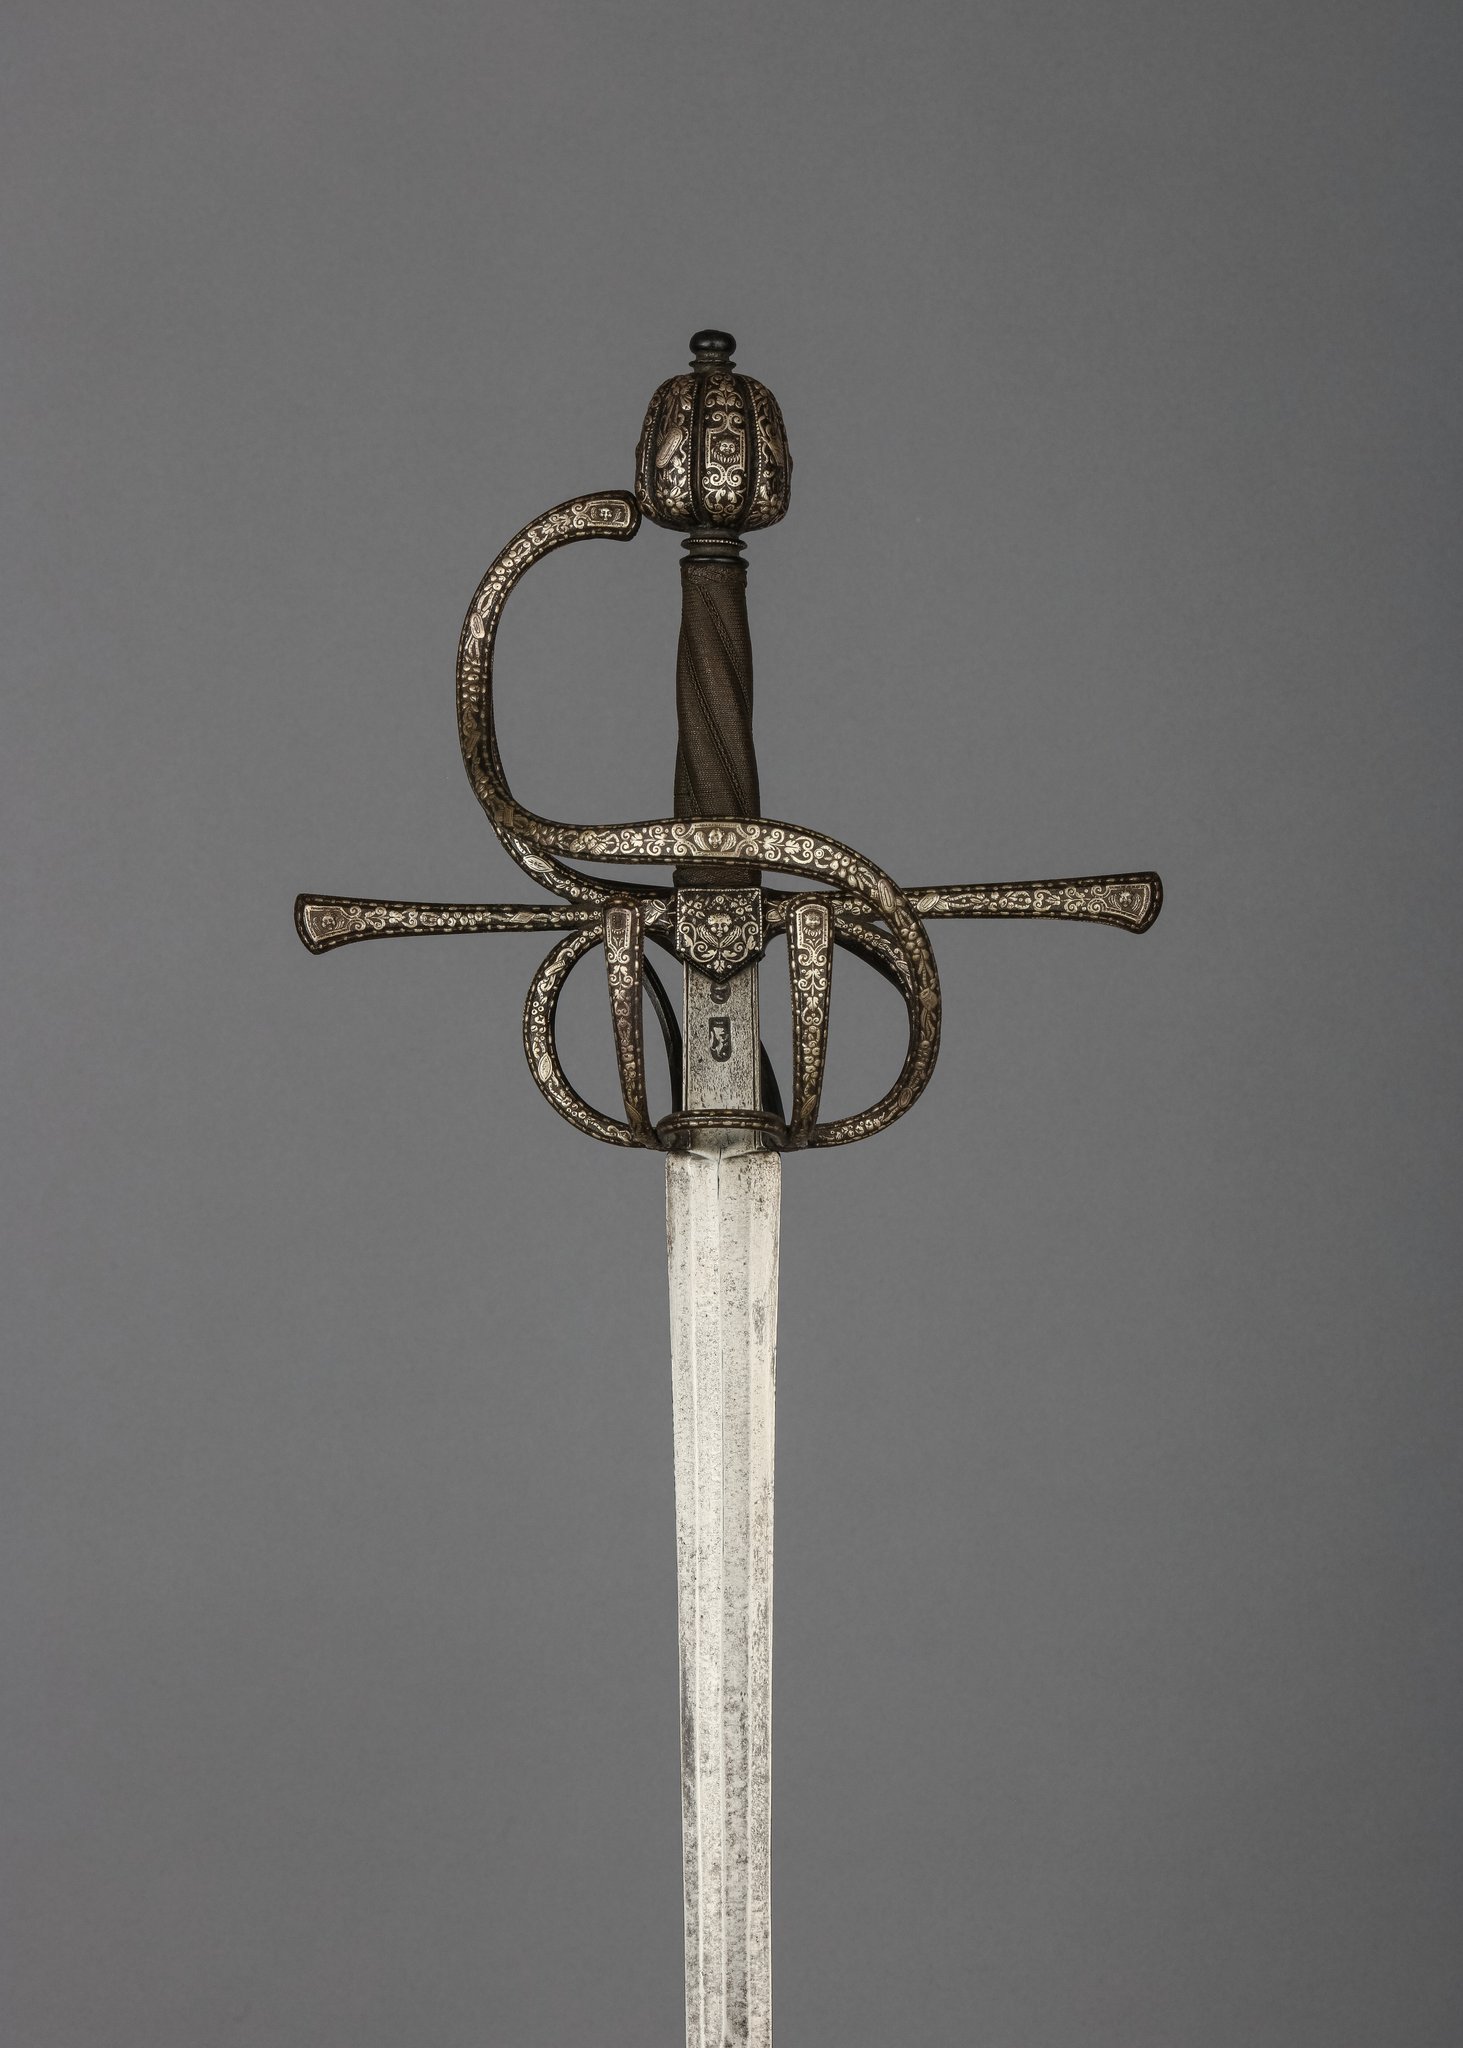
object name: rapier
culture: german or italian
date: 1580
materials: copper, silver, steel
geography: germany